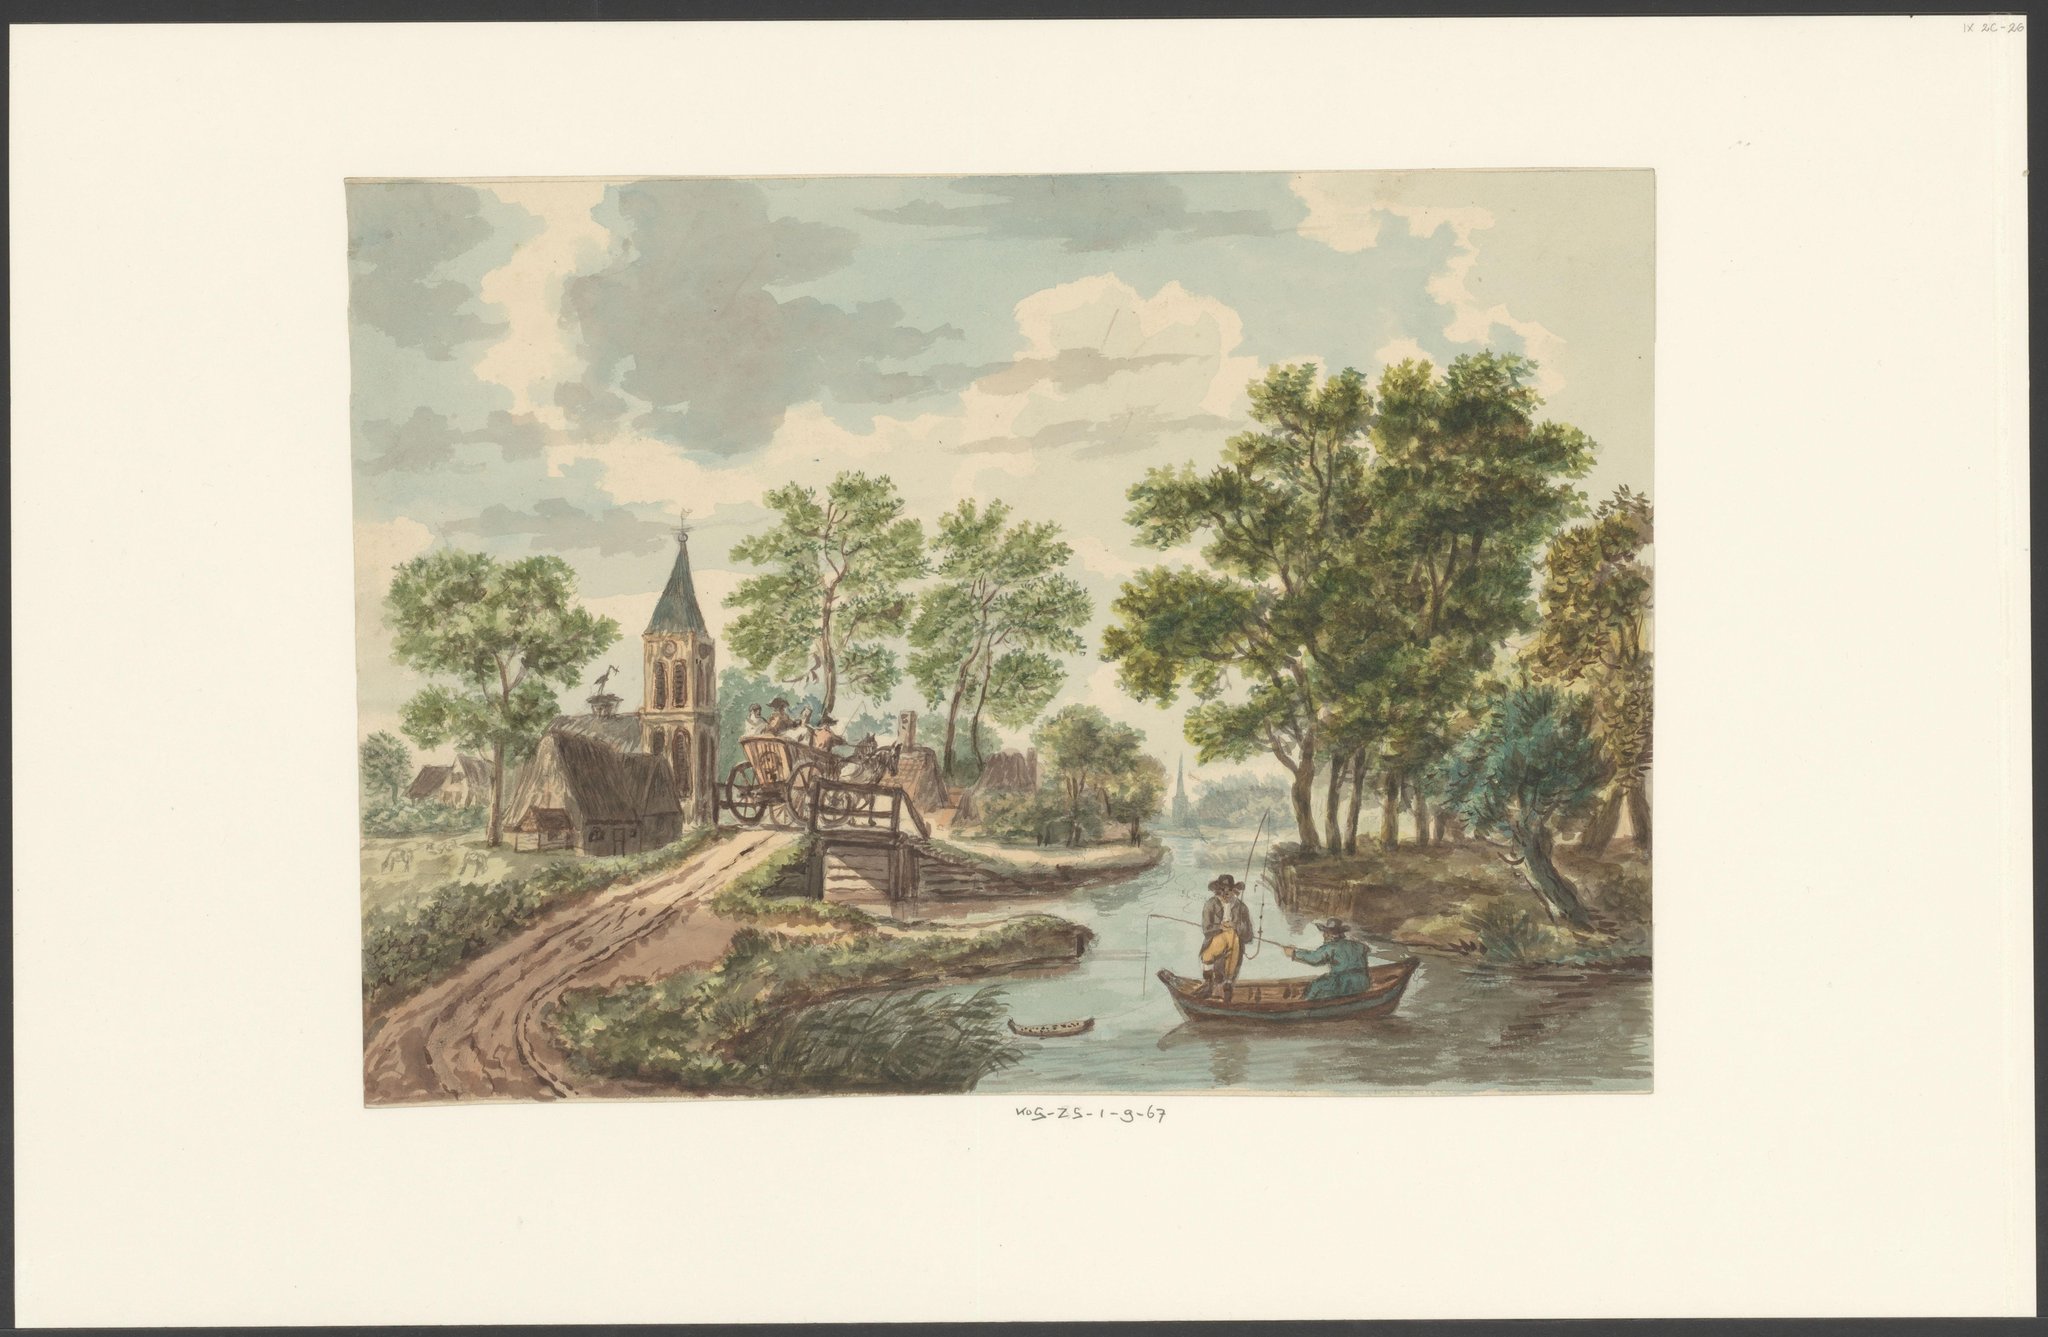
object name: drawing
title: Twee vissers op een rivier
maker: Anonymous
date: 1700-1799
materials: ink, paper, watercolor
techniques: brush, pen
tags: river, church (exterior), four-wheeled vehicle drawn by two animals, fisherman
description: Twee vissers in een open boot op een rivier. Langs de rivier loopt een weg waar een koets over rijdt richting een dorp. Onderwerpsrubrieken binnen de Atlas Zeden en Gewoonten: Handel, nijverheid en verkeer, Zee- en Riviervisscherij.